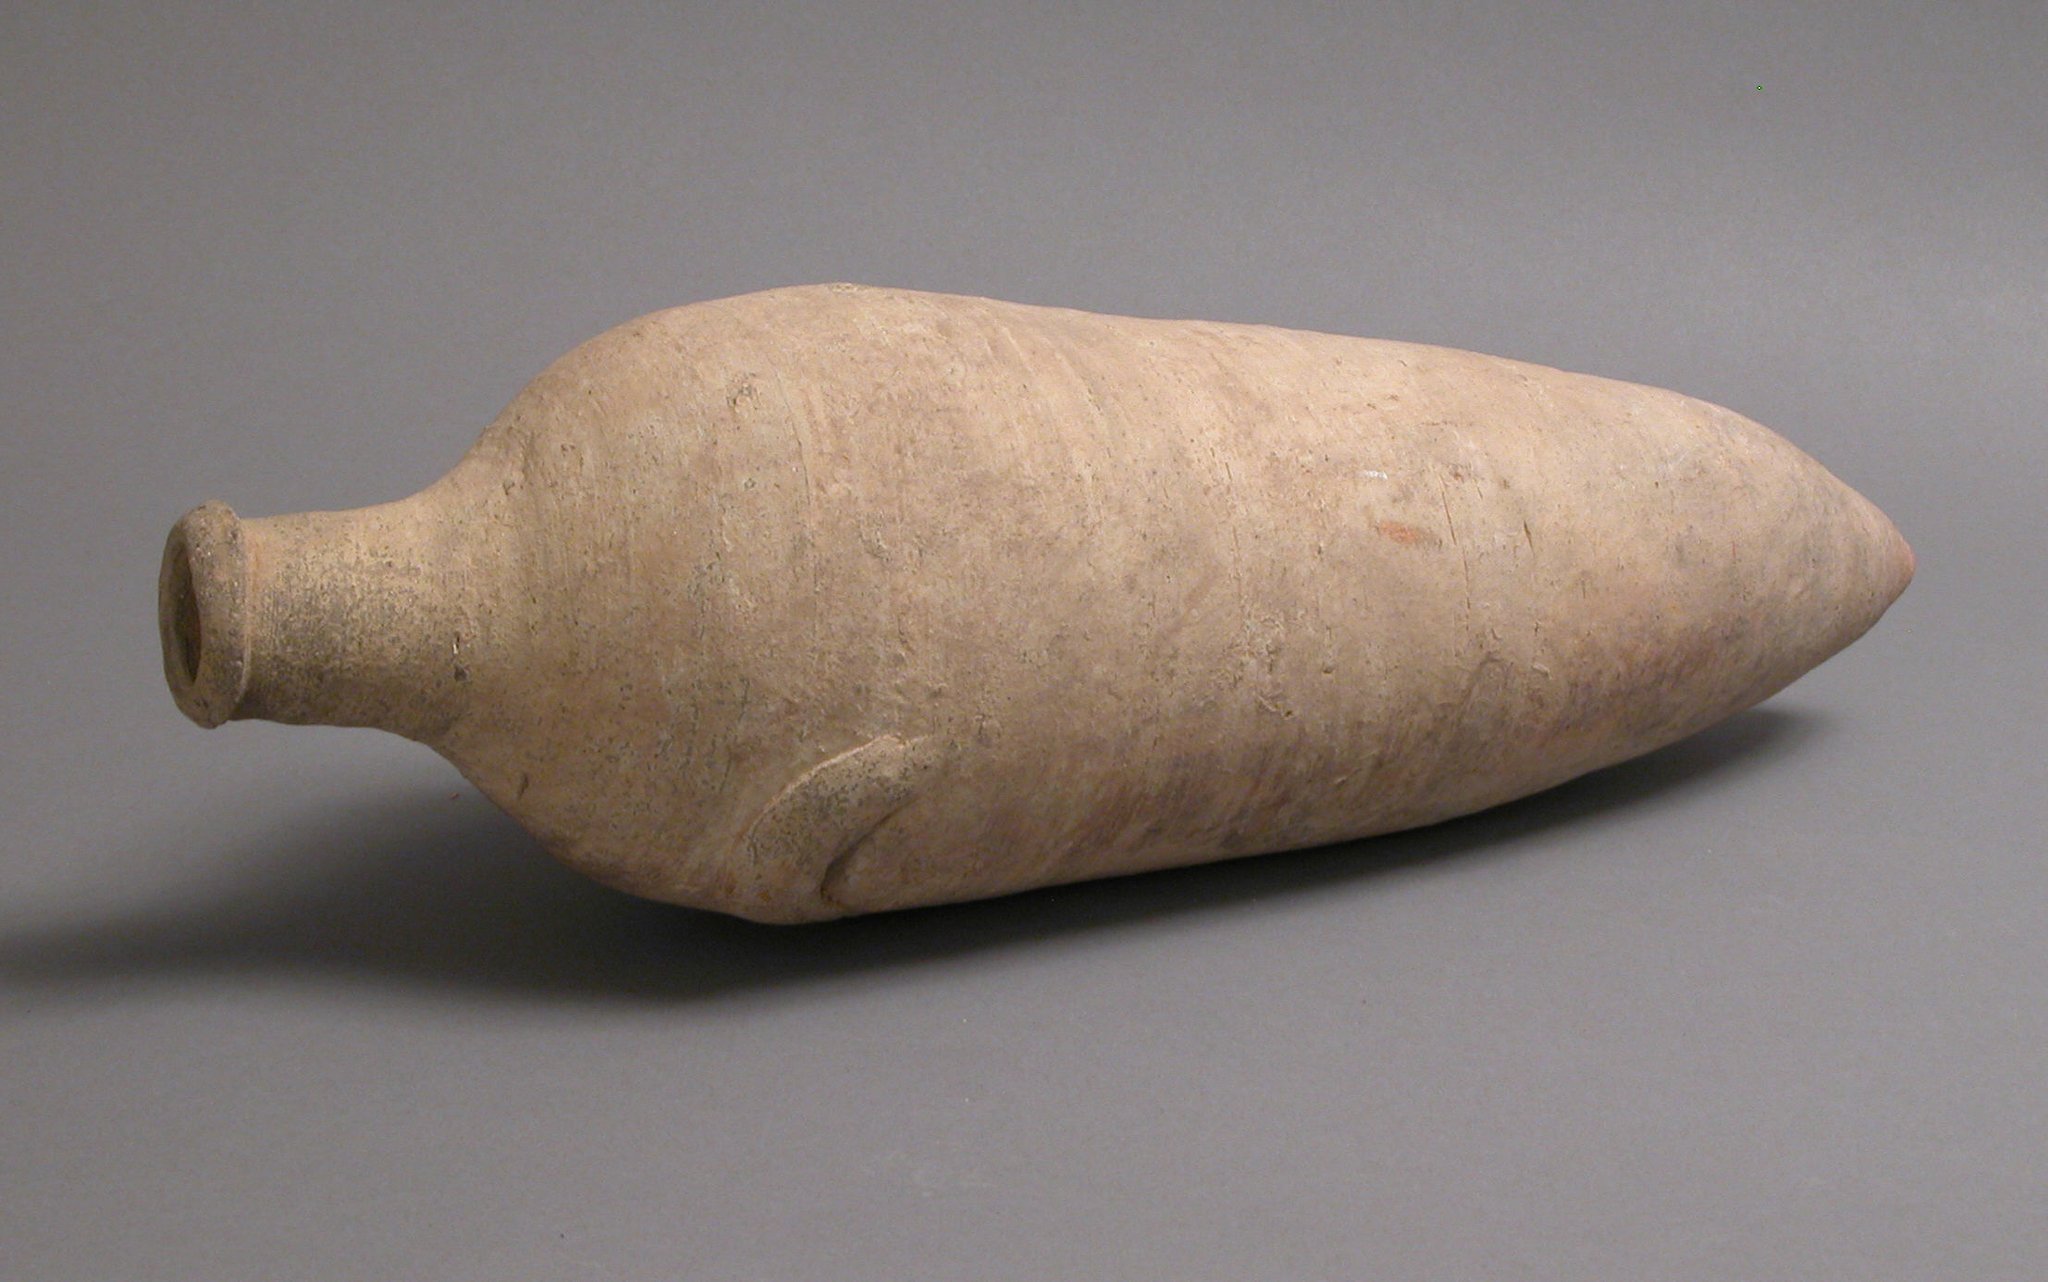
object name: jar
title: Oil Jar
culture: coptic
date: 301-700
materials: earthenware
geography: egypt